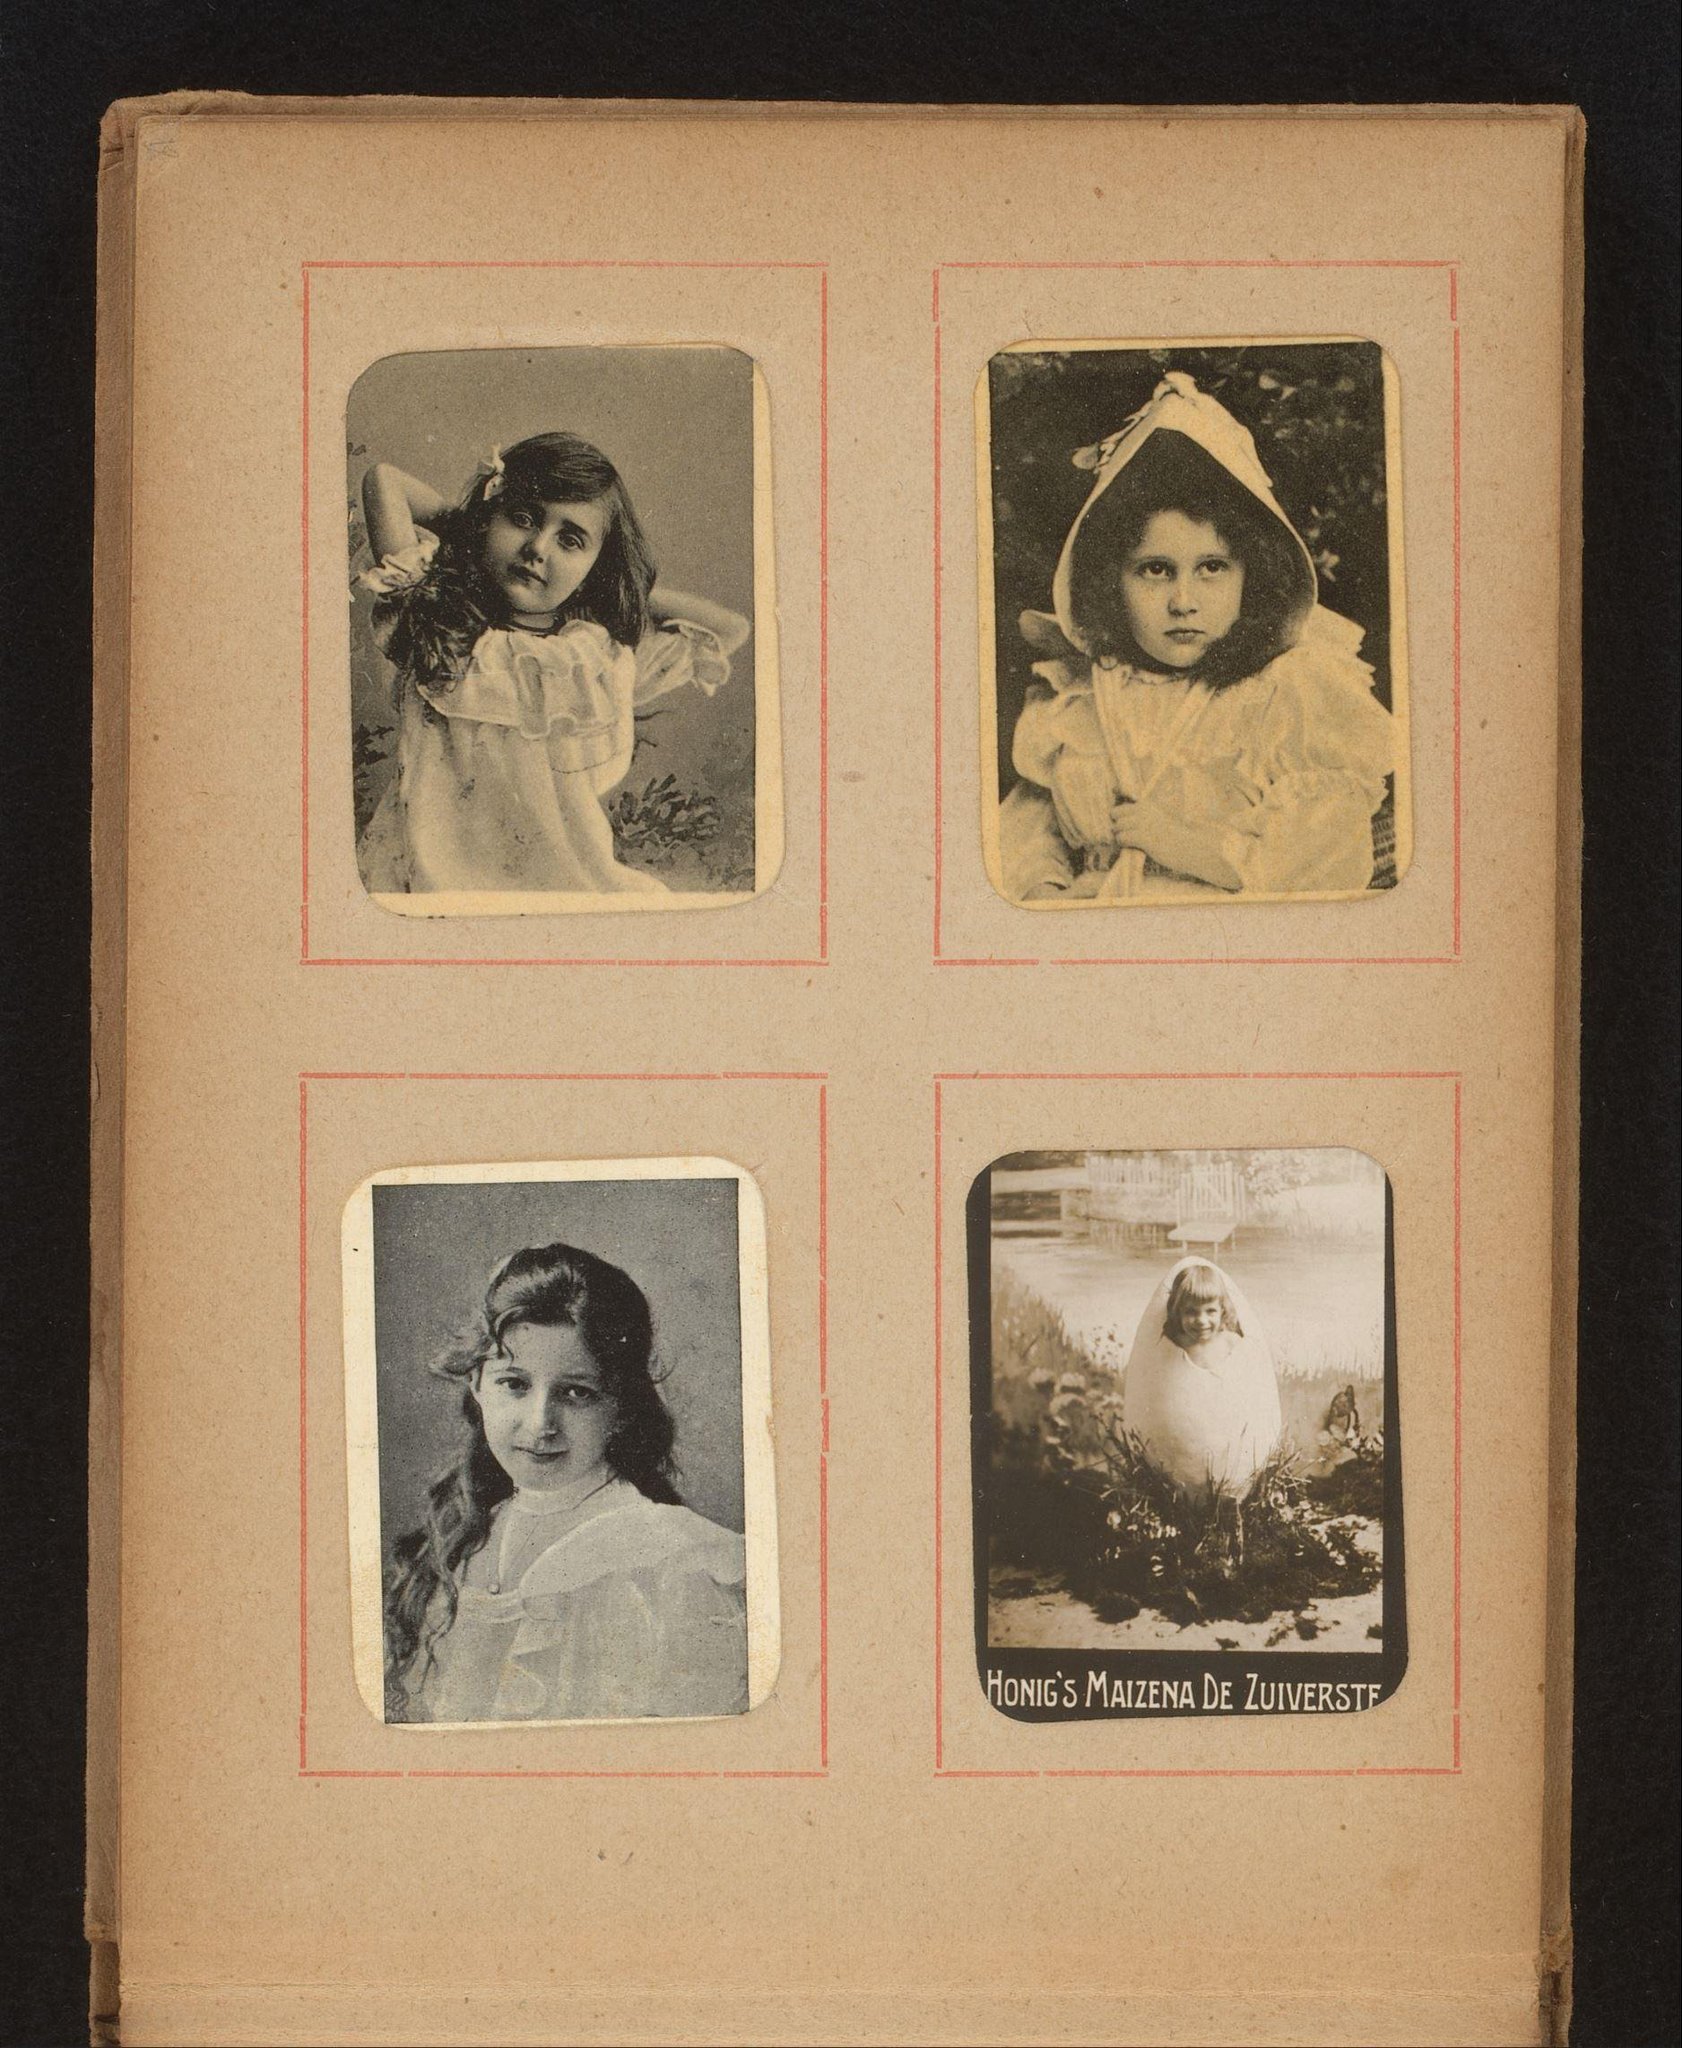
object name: photomechanical print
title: Kinderportretten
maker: Anonymous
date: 1880-1920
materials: paper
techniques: photograph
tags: child, trade games, imitative games, imitating adults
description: Vier portretten van kinderen, waaronder een van een kind in een ei met het opschrift Honig's Maizena de Zuiverste. Deze pagina maakt deel uit van een album.